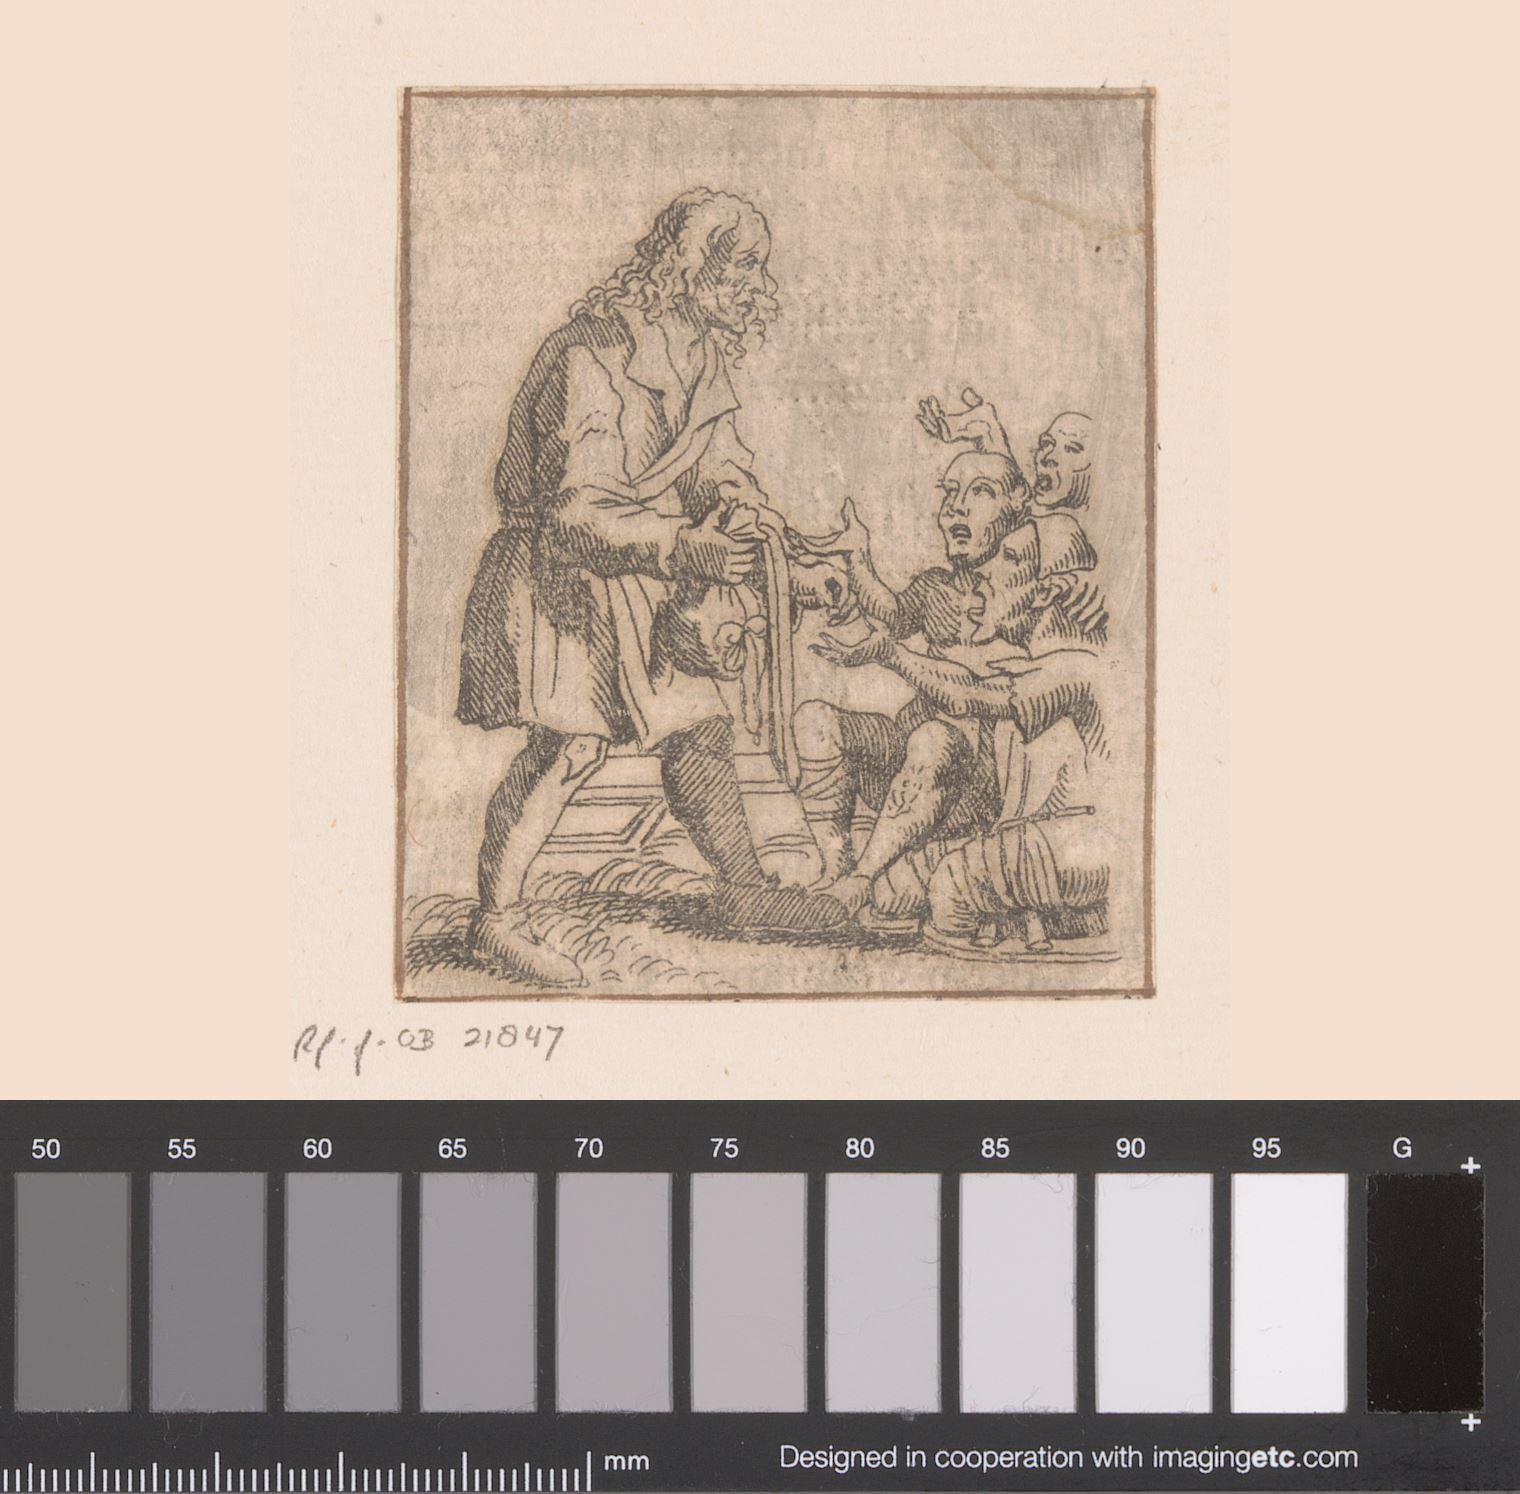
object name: print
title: Ware christen, gekleed in lompen, deelt aalmoezen uit aan bedelaars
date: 1516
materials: paper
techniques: etching, letterpress printing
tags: desiderius erasmus, giving alms or other charity, e.g.: handing out food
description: Prent afkomstig uit: Erasmus, Desiderius. Morias enkomion (...). Bazel: Johann Rudolf Genath, 1676. De prenten hierin zijn naar tekeningen die Hans en Ambrosius Holbein maakten voor de theoloog Oswald Myconius in diens uitgave van de Moriae encomium (Lof der Zotheid) van 1516.